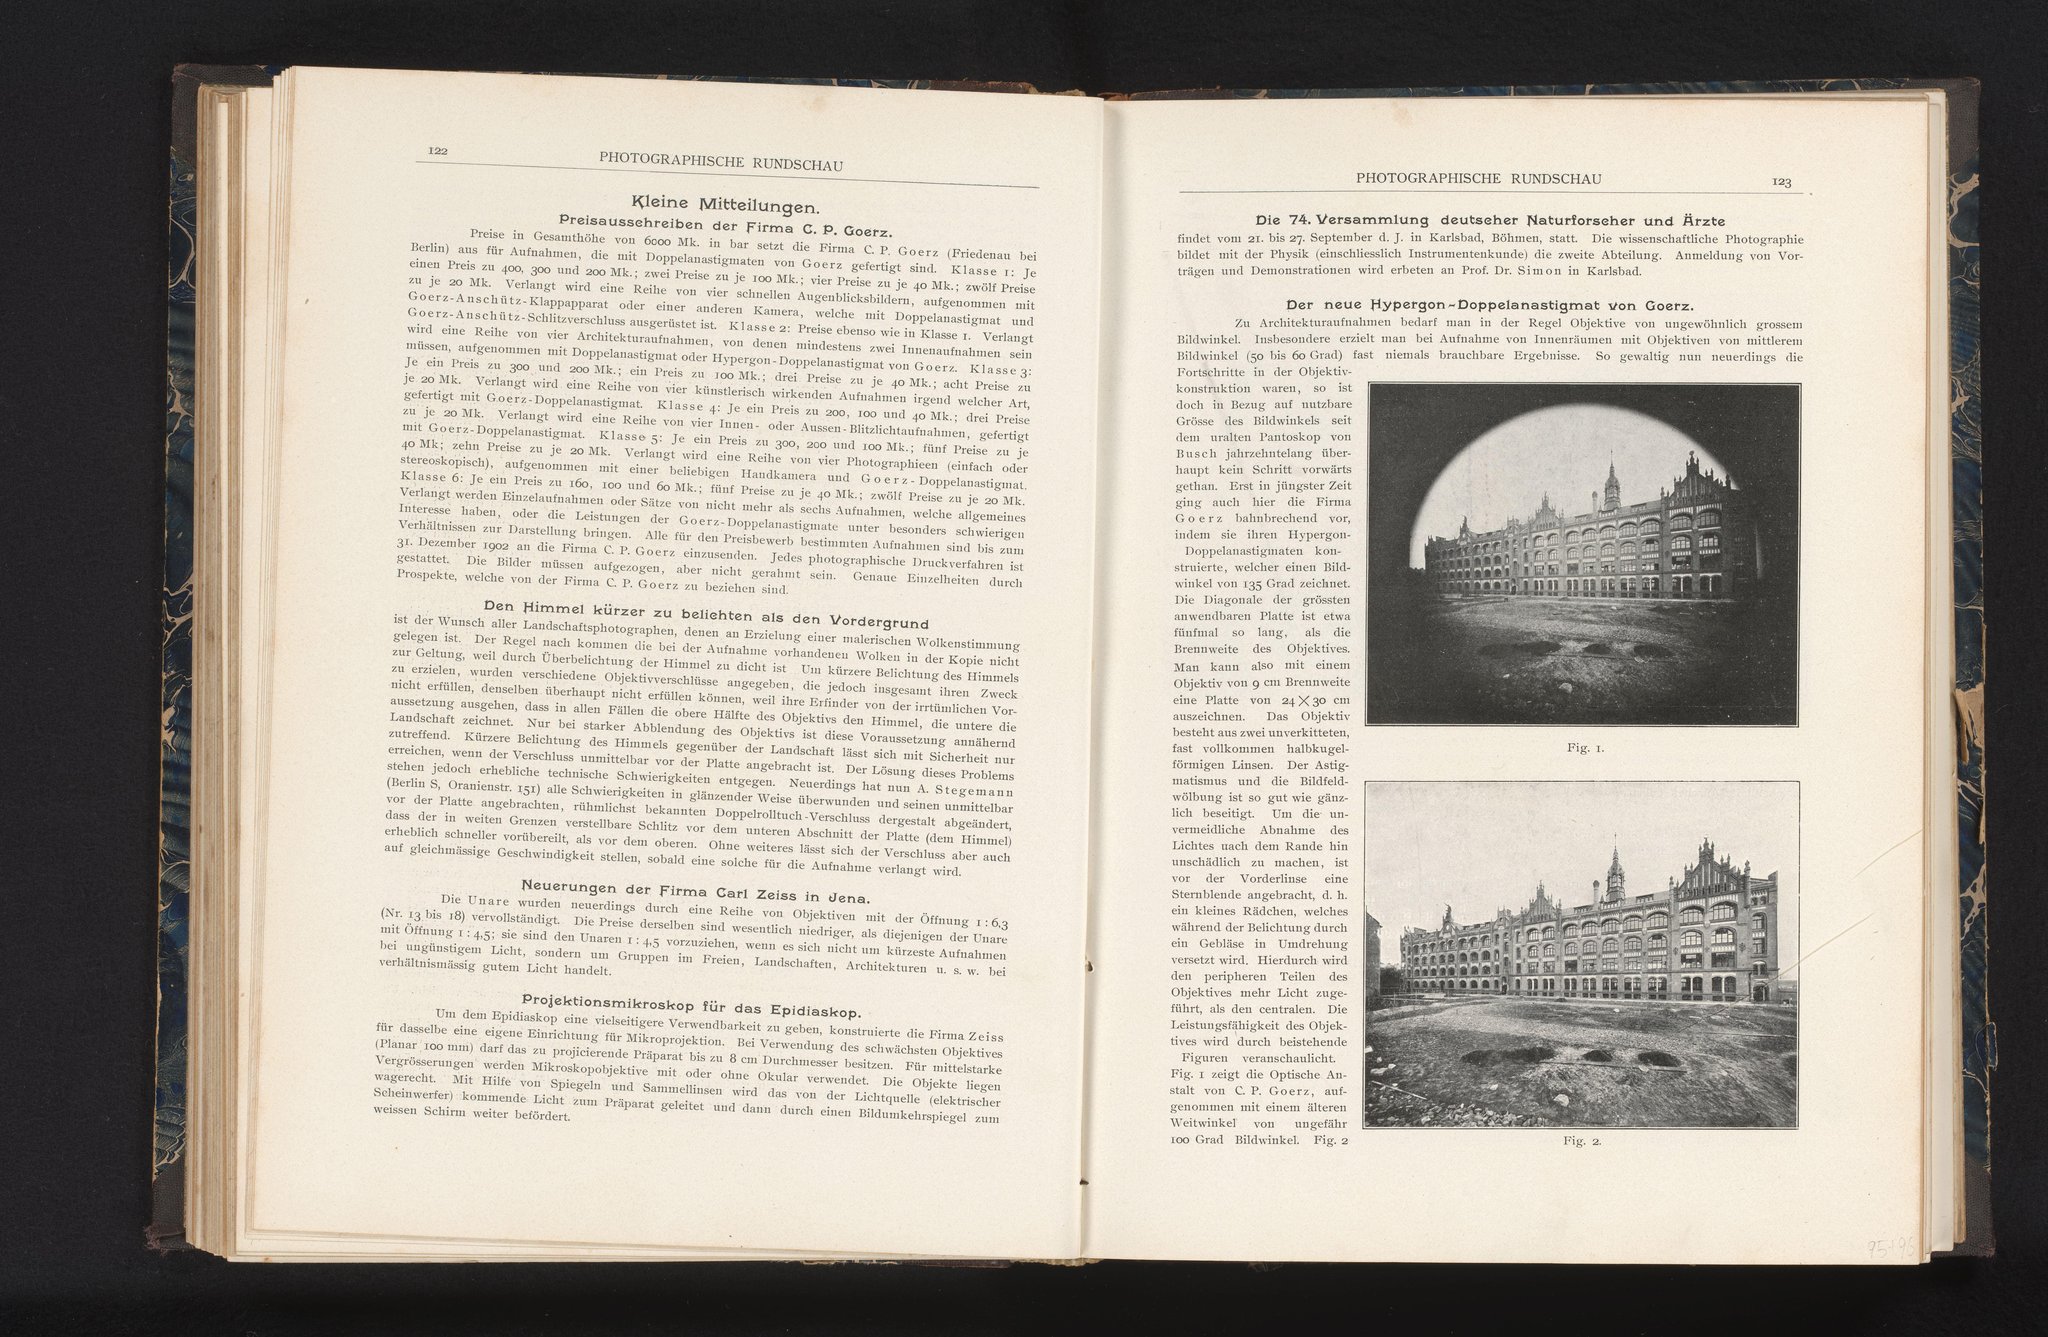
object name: photomechanical print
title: Gezicht op de façade van een gebouw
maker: Anonymous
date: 1897-1902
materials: paper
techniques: autotype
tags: front façade